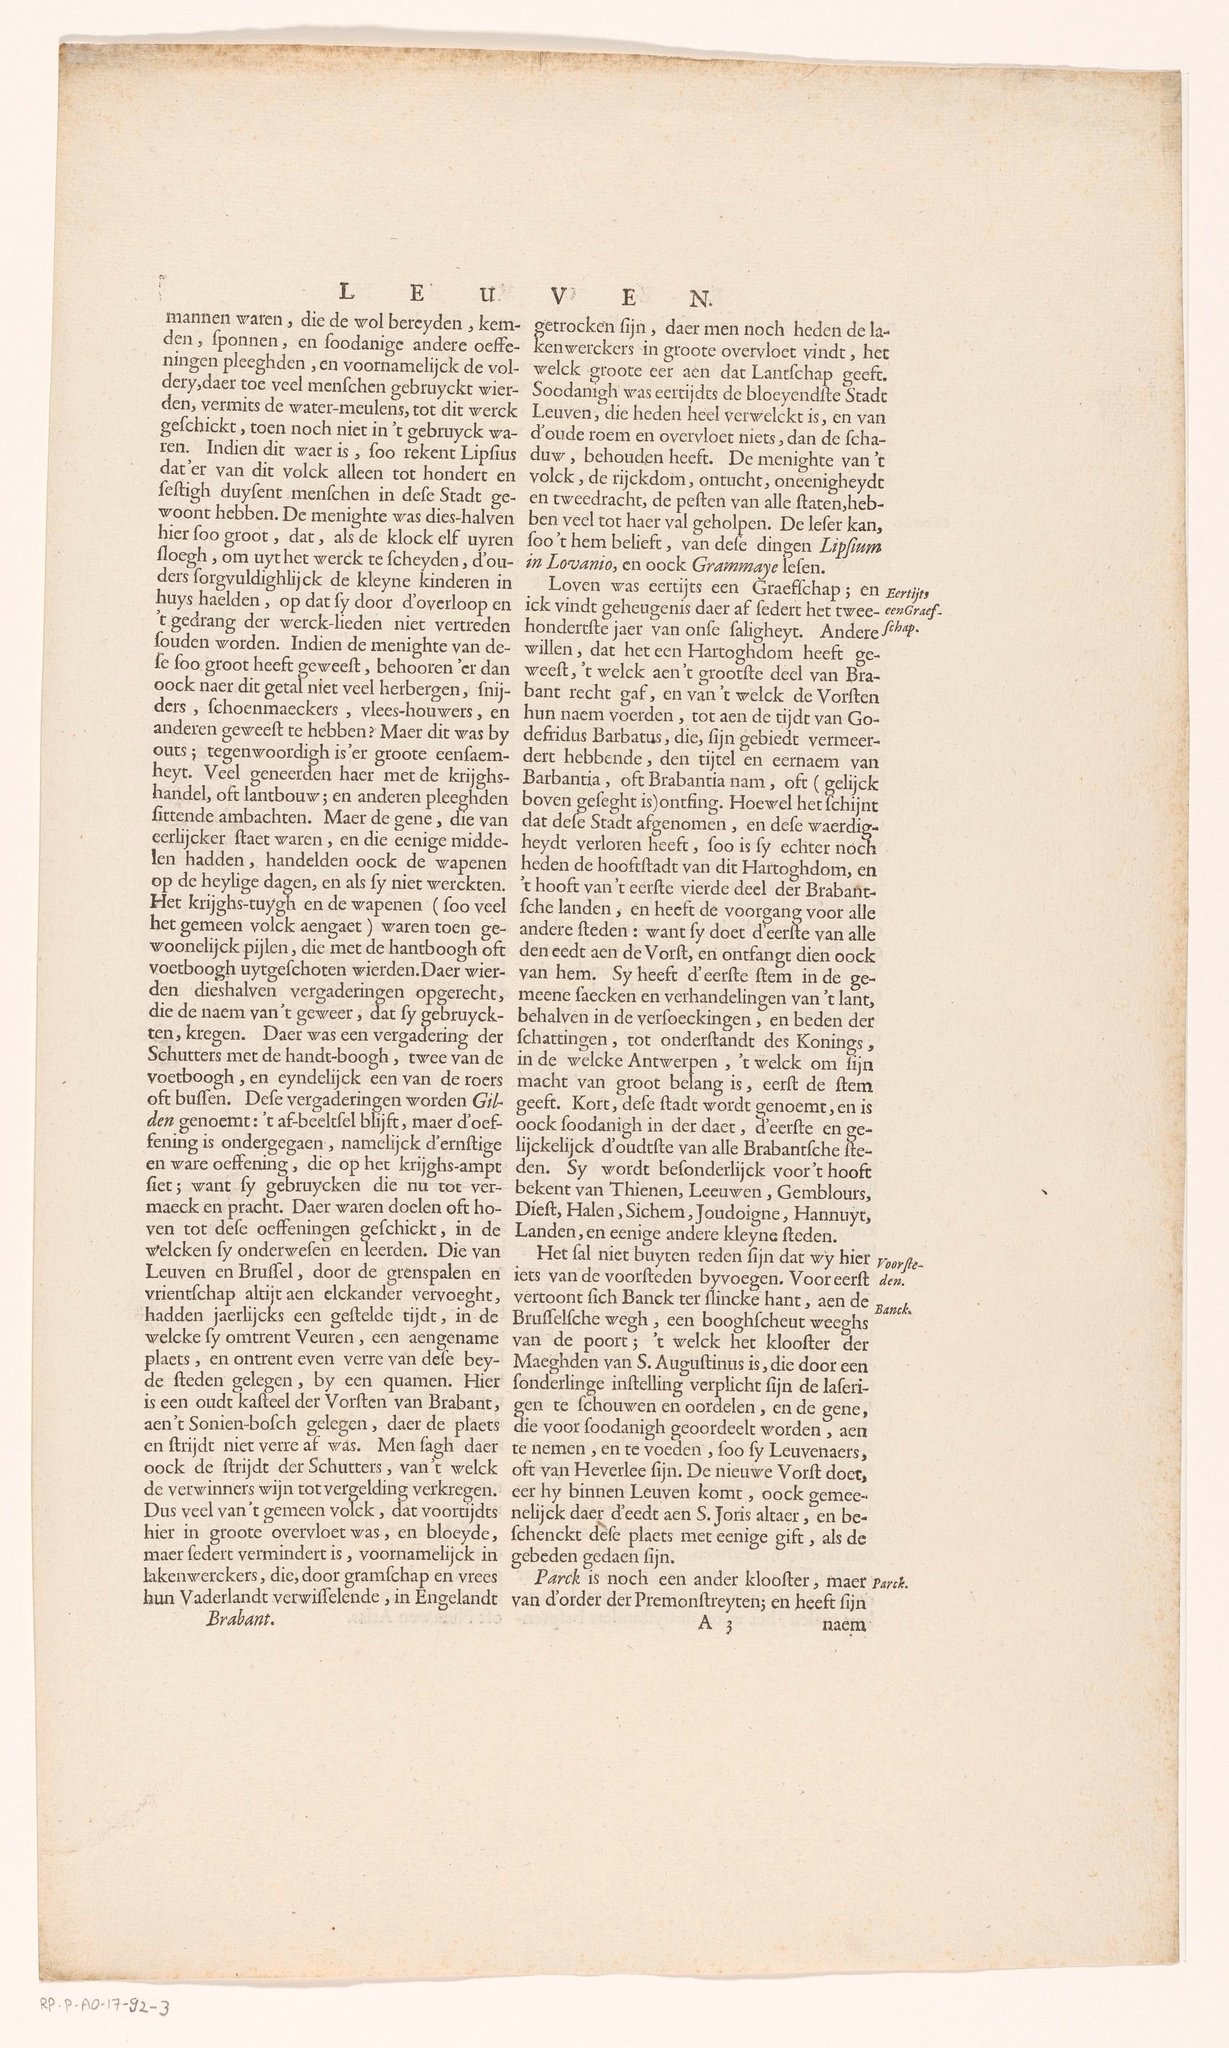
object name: text sheet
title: Deel van de beschrijving van Leuven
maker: johannes willemszoon blaeu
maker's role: printer, publisher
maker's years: 1596-1673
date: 1652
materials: paper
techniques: letterpress printing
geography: amsterdam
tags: louvain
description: Tekst gebruikt in: Blaeu, Johannes Willemszoon. Toonneel der steden van de Vereenighde Nederlanden. 2 delen. Amsterdam: Johannes Willemszoon Blaeu, 1652, dl. 2. Zie ook: RP-P-AO-17-92-1 en RP-P-AO-17-92-2.